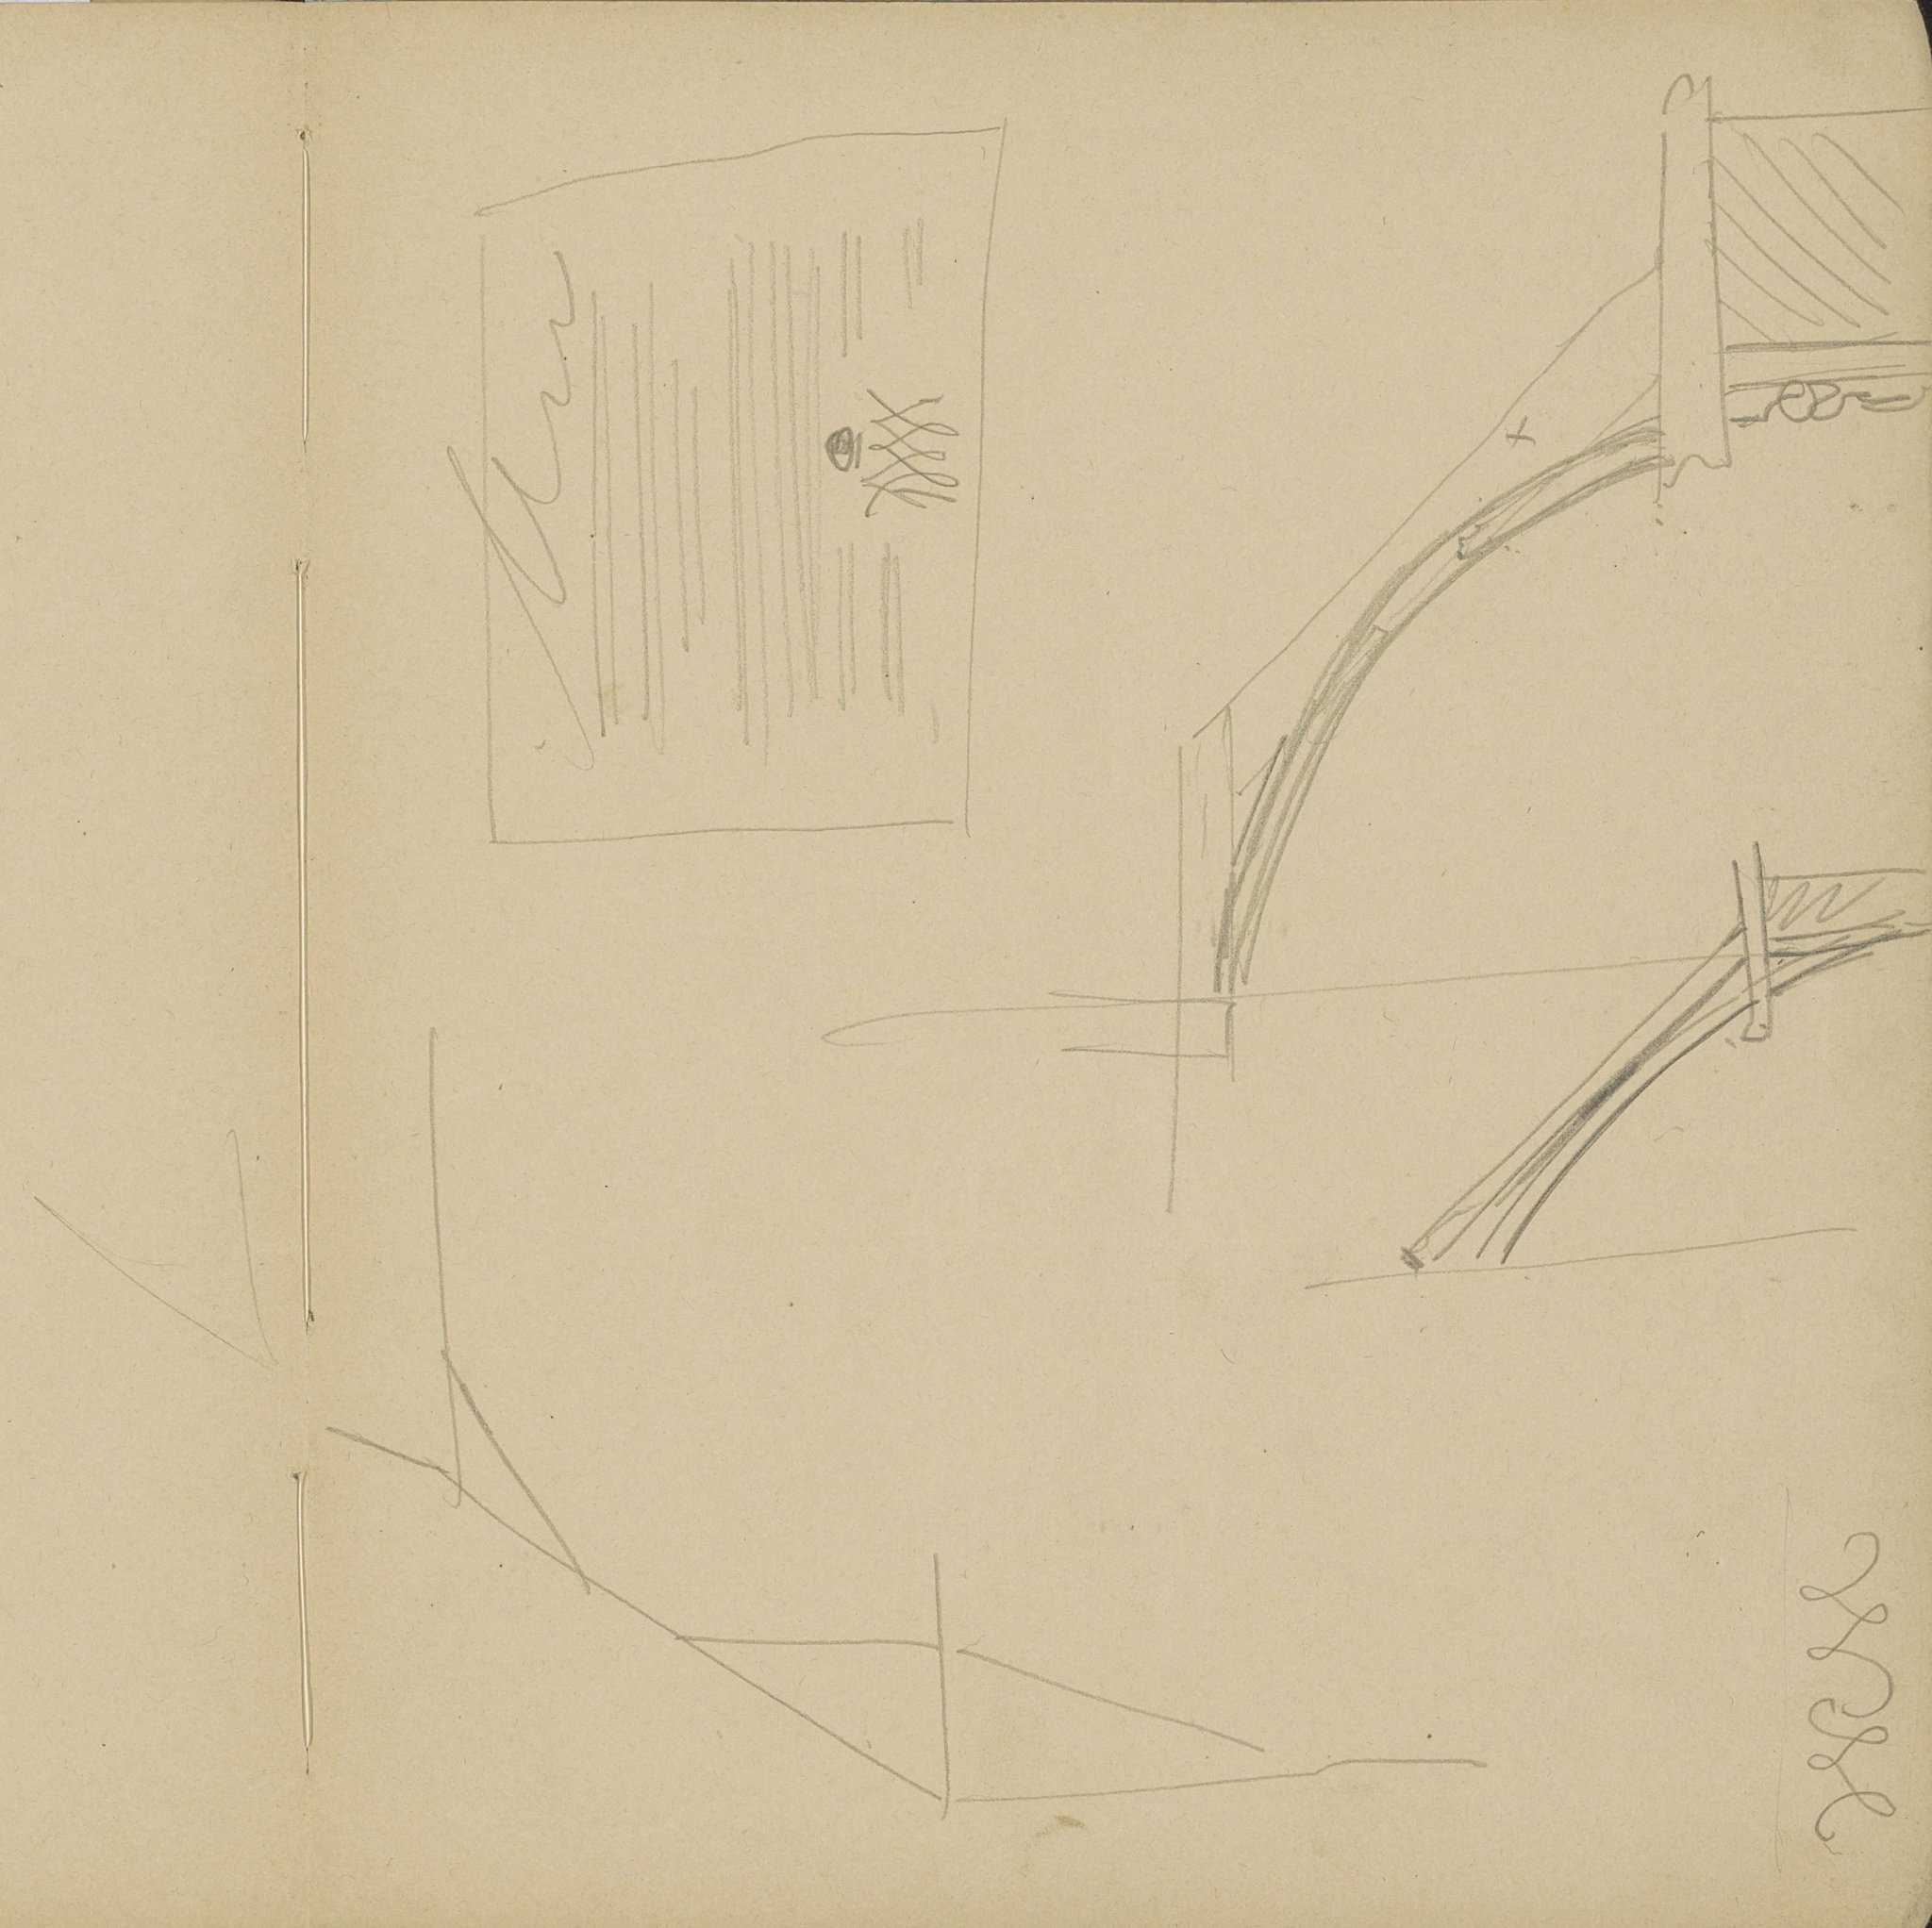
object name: sketchbook leaf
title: Boogconstructie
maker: carel adolph lion cachet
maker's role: draughtsman, print maker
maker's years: 1864-1945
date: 1905-1906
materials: paper, pencil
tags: arch, archivolt ~ architecture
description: Blad 26 recto uit een schetsboek met 30 bladen.